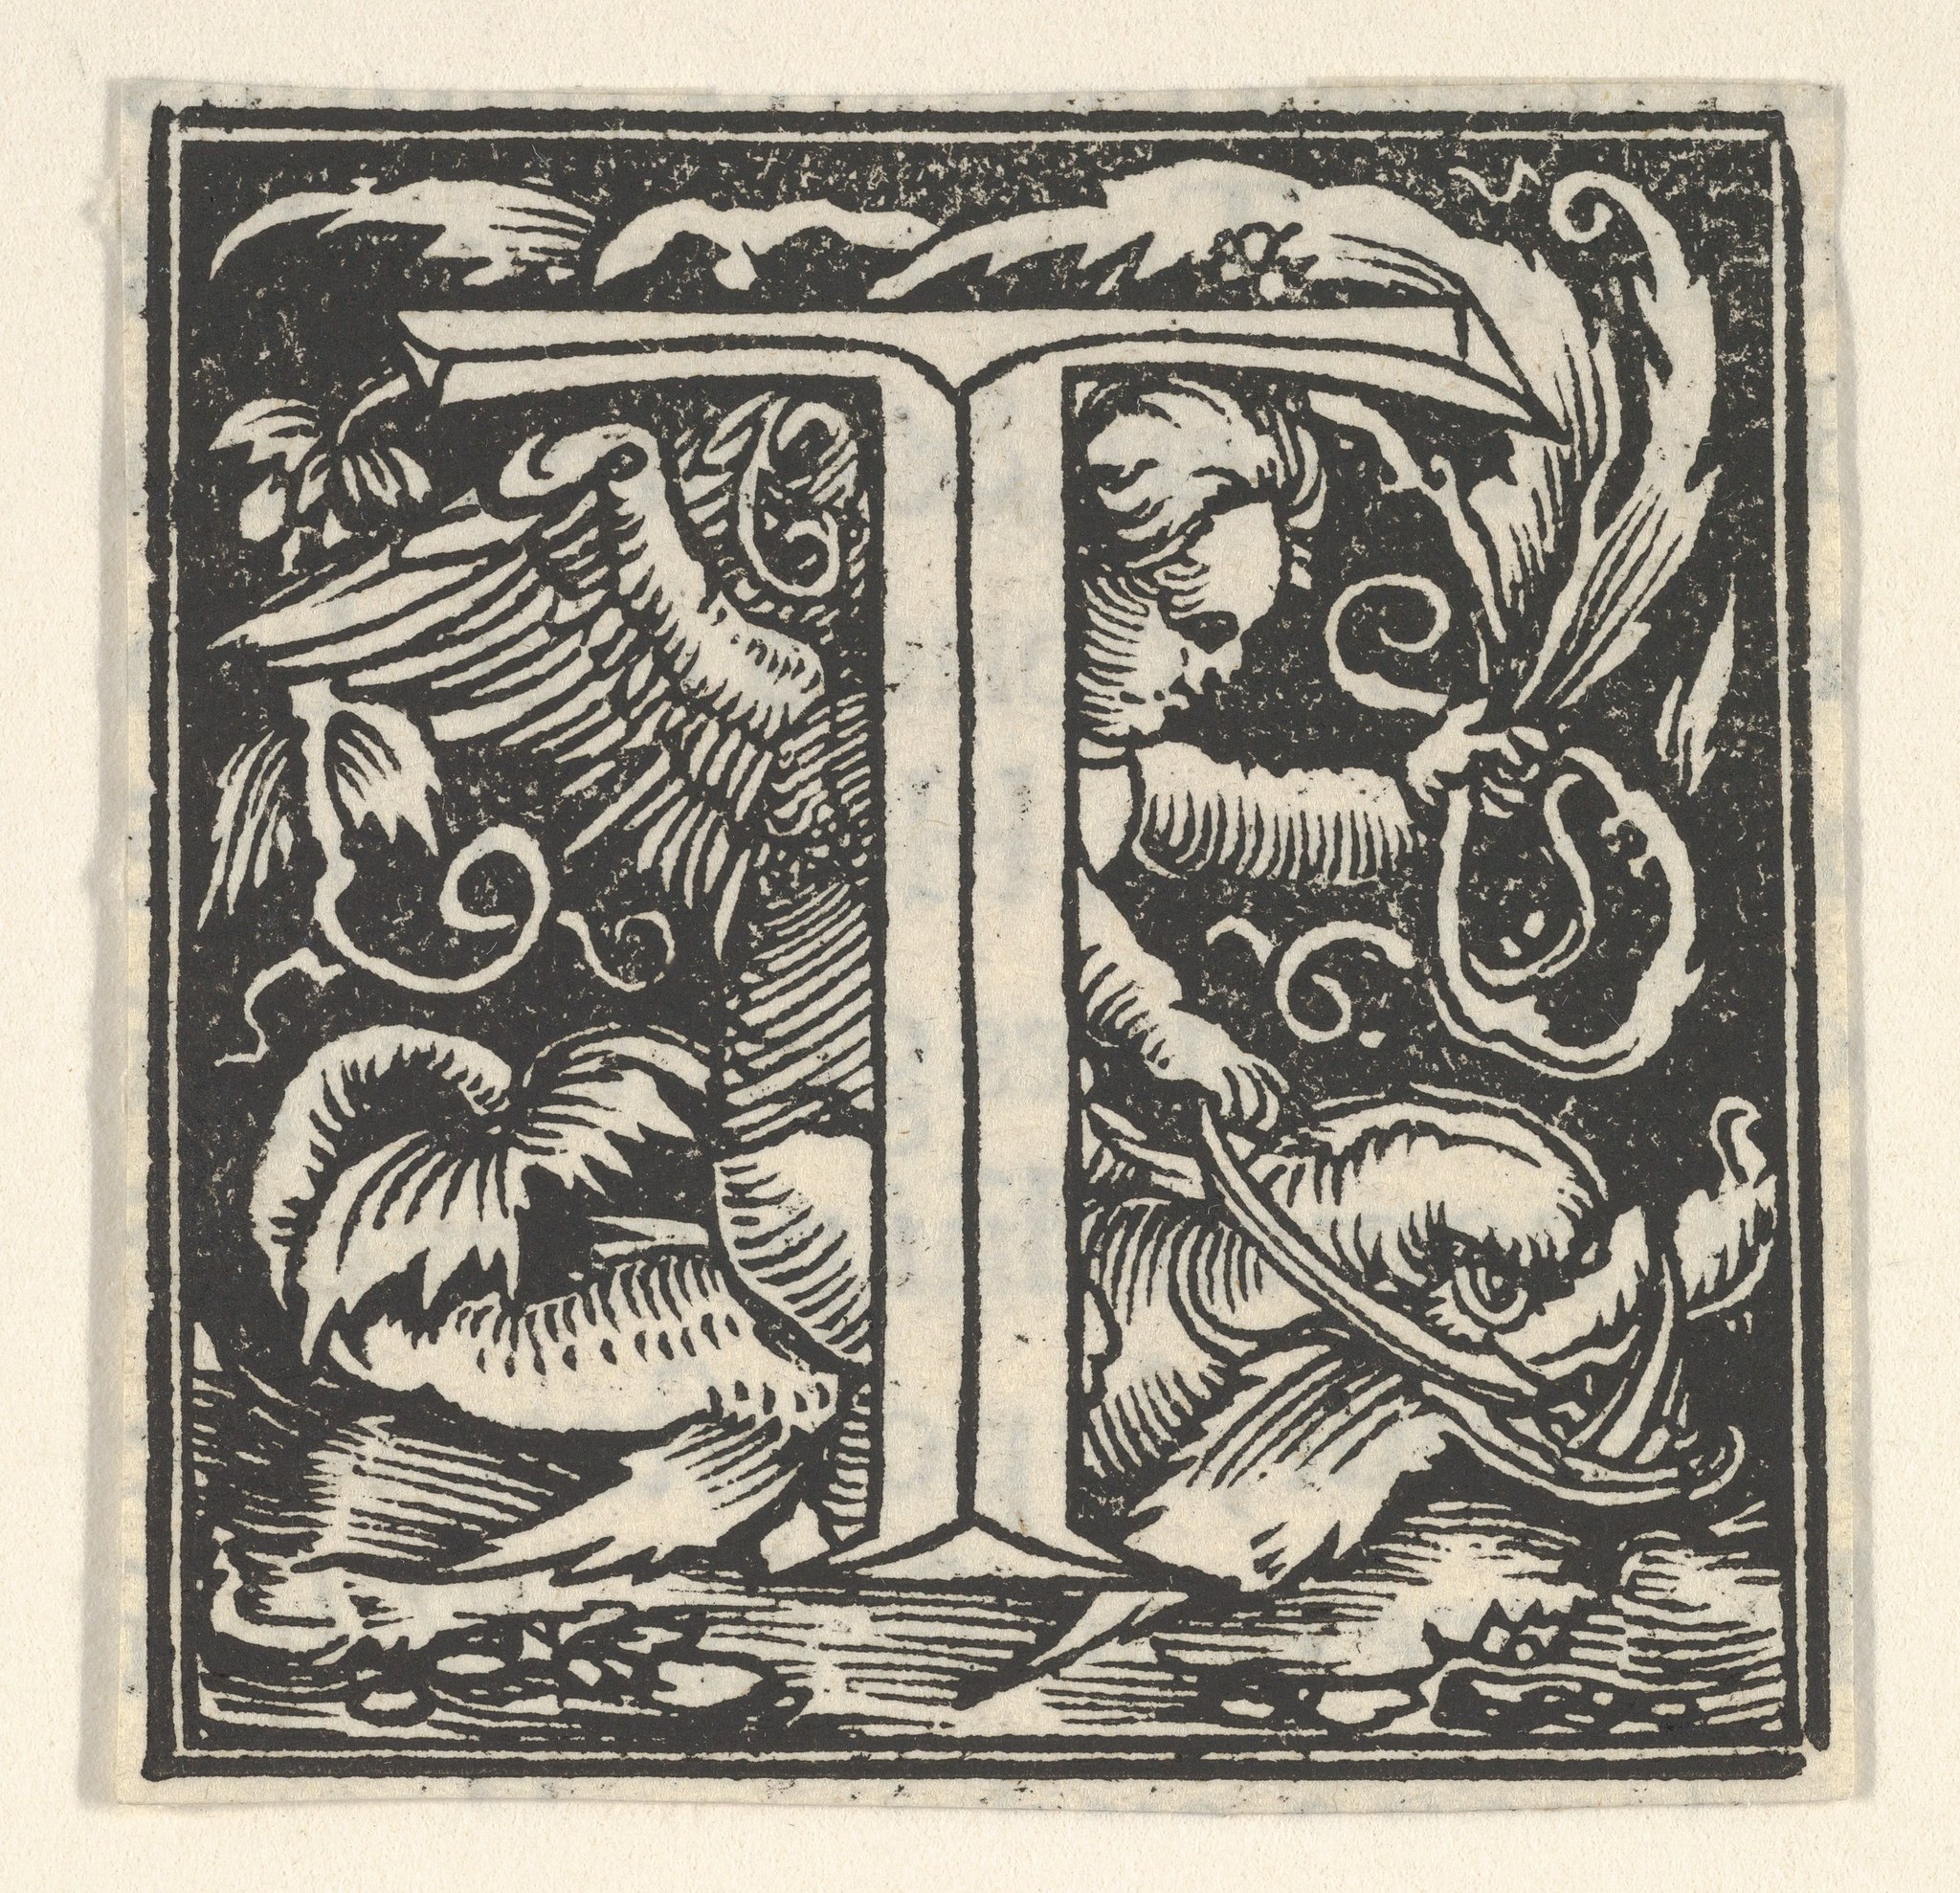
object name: print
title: Initial letter T with putto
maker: heinrich vogtherr the elder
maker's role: artist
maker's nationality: german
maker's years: 1538-1540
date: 1538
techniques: woodcut